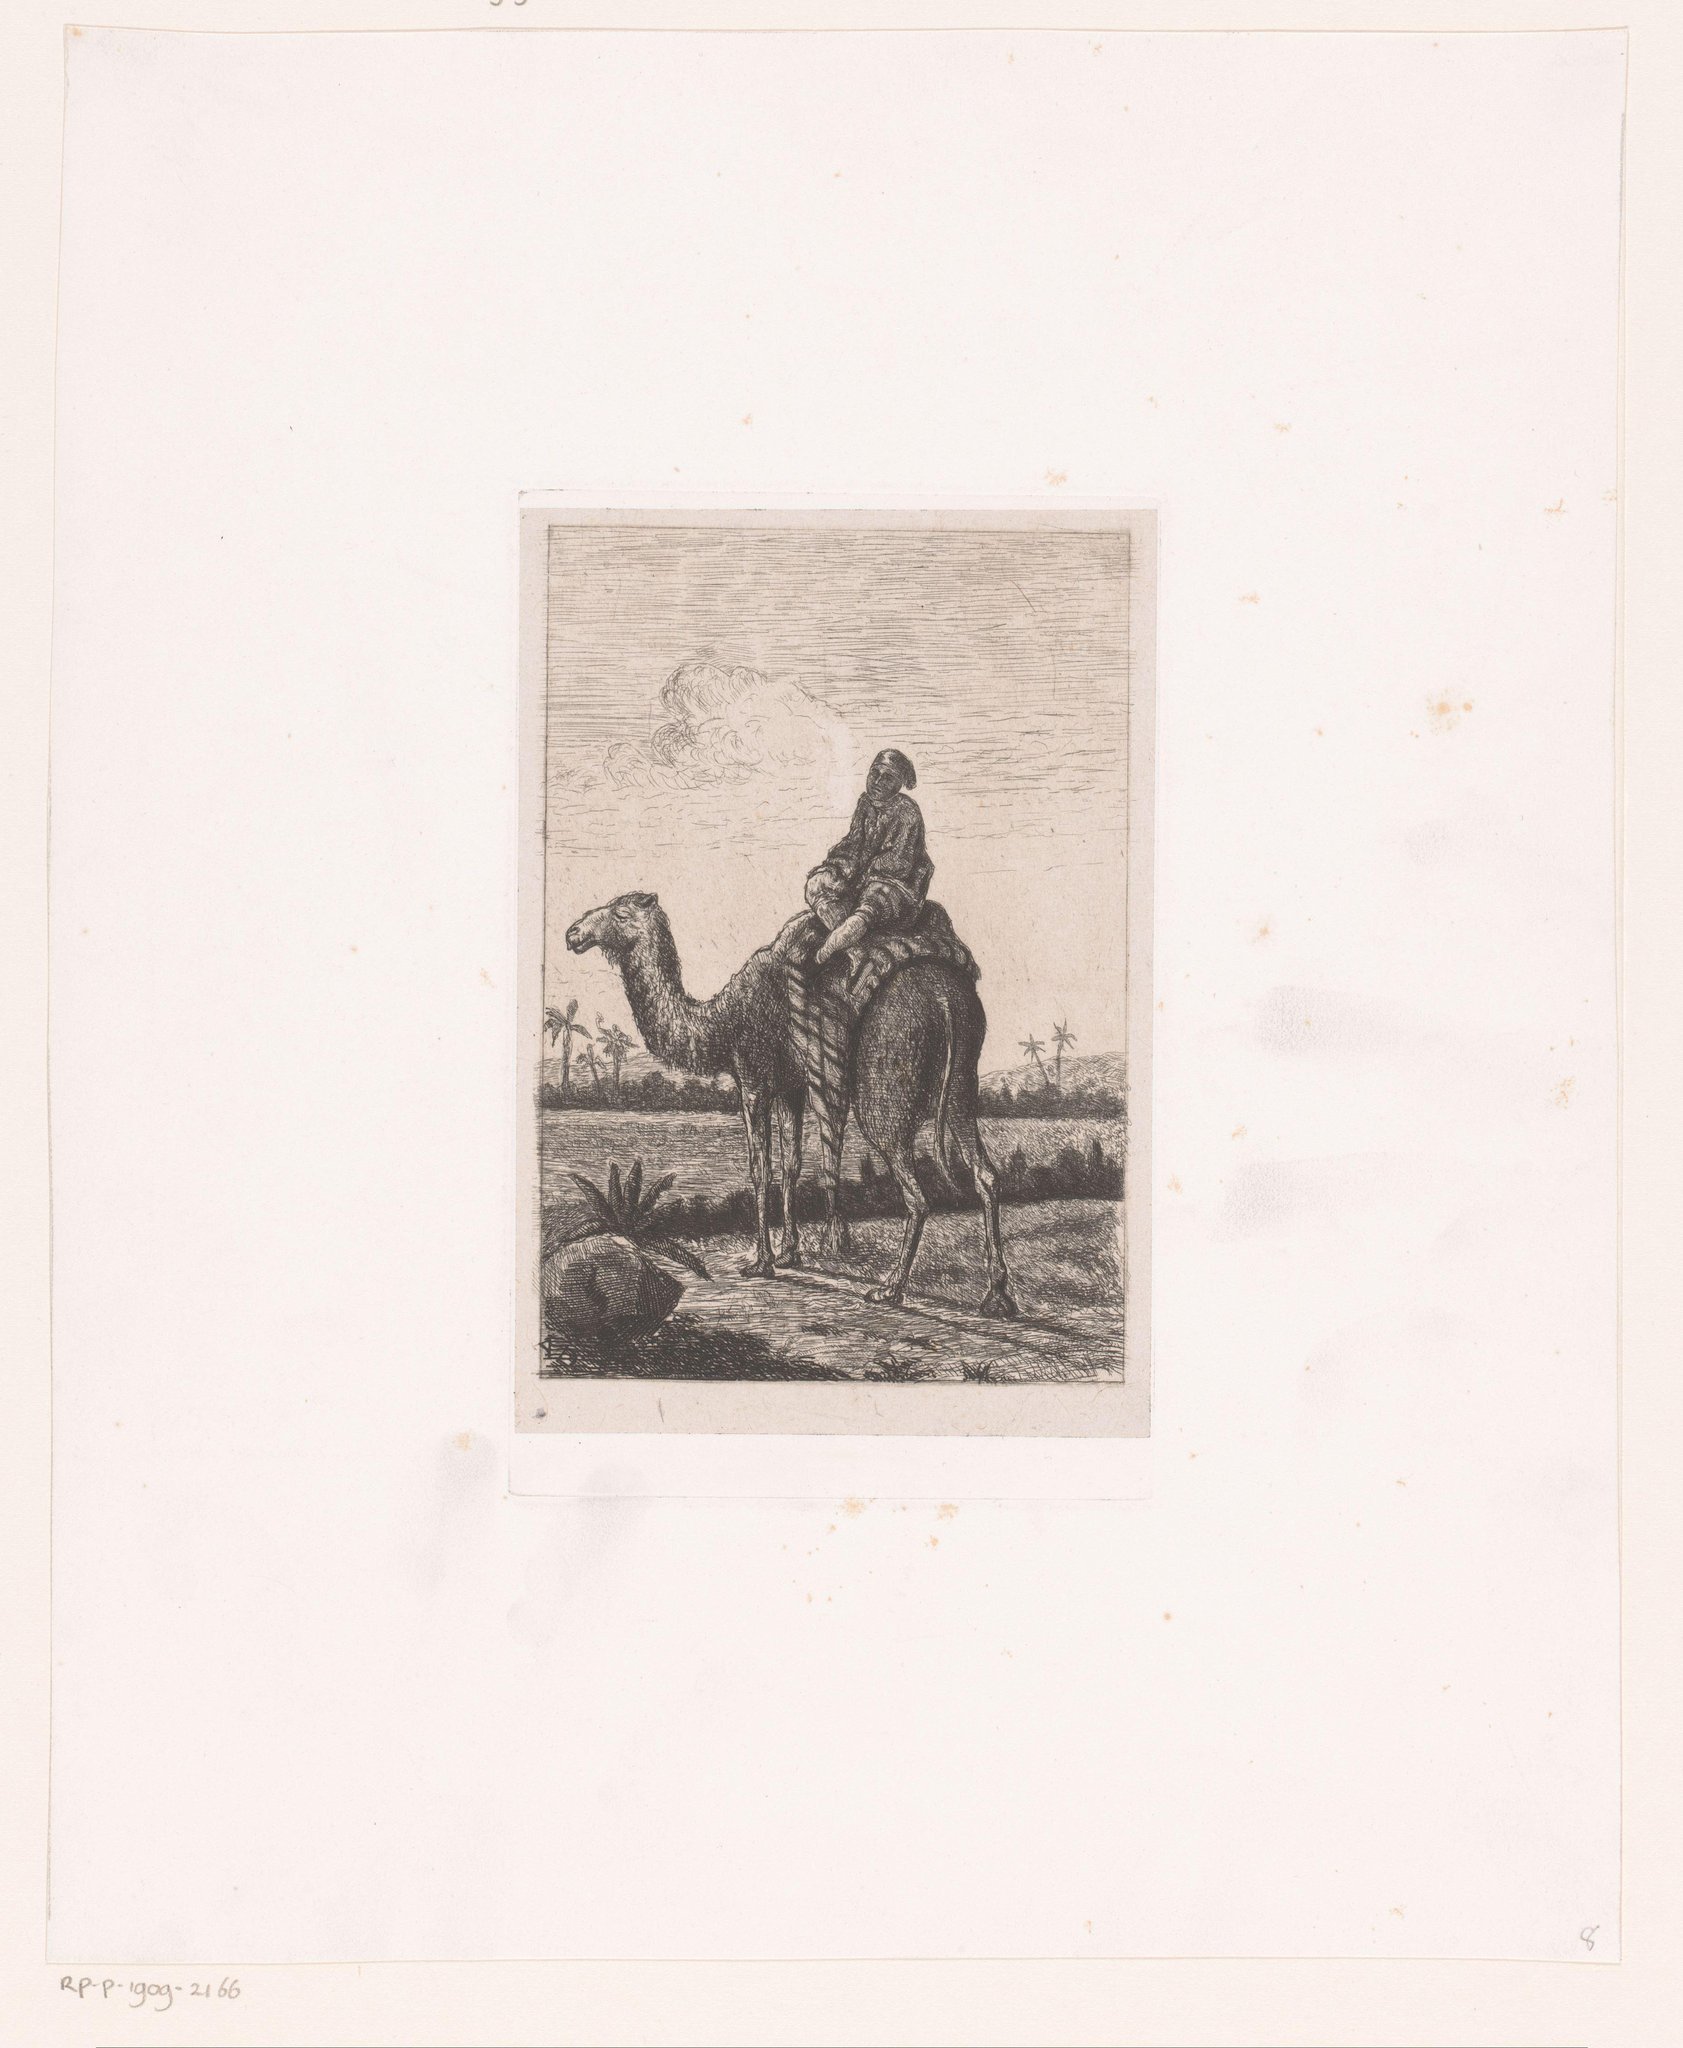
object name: print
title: Souvenirs uit Tunis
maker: vicomte arthur-jean le bailly dinghuem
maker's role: print maker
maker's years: 1839-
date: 1875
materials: paper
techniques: etching, intaglio, roulette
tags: landscapes, hoofed animals: dromedary, riding on animal other than horse, ass, or mule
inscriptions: collector's mark: Lugt 2228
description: Onderdeel van een serie van twaalf prenten.